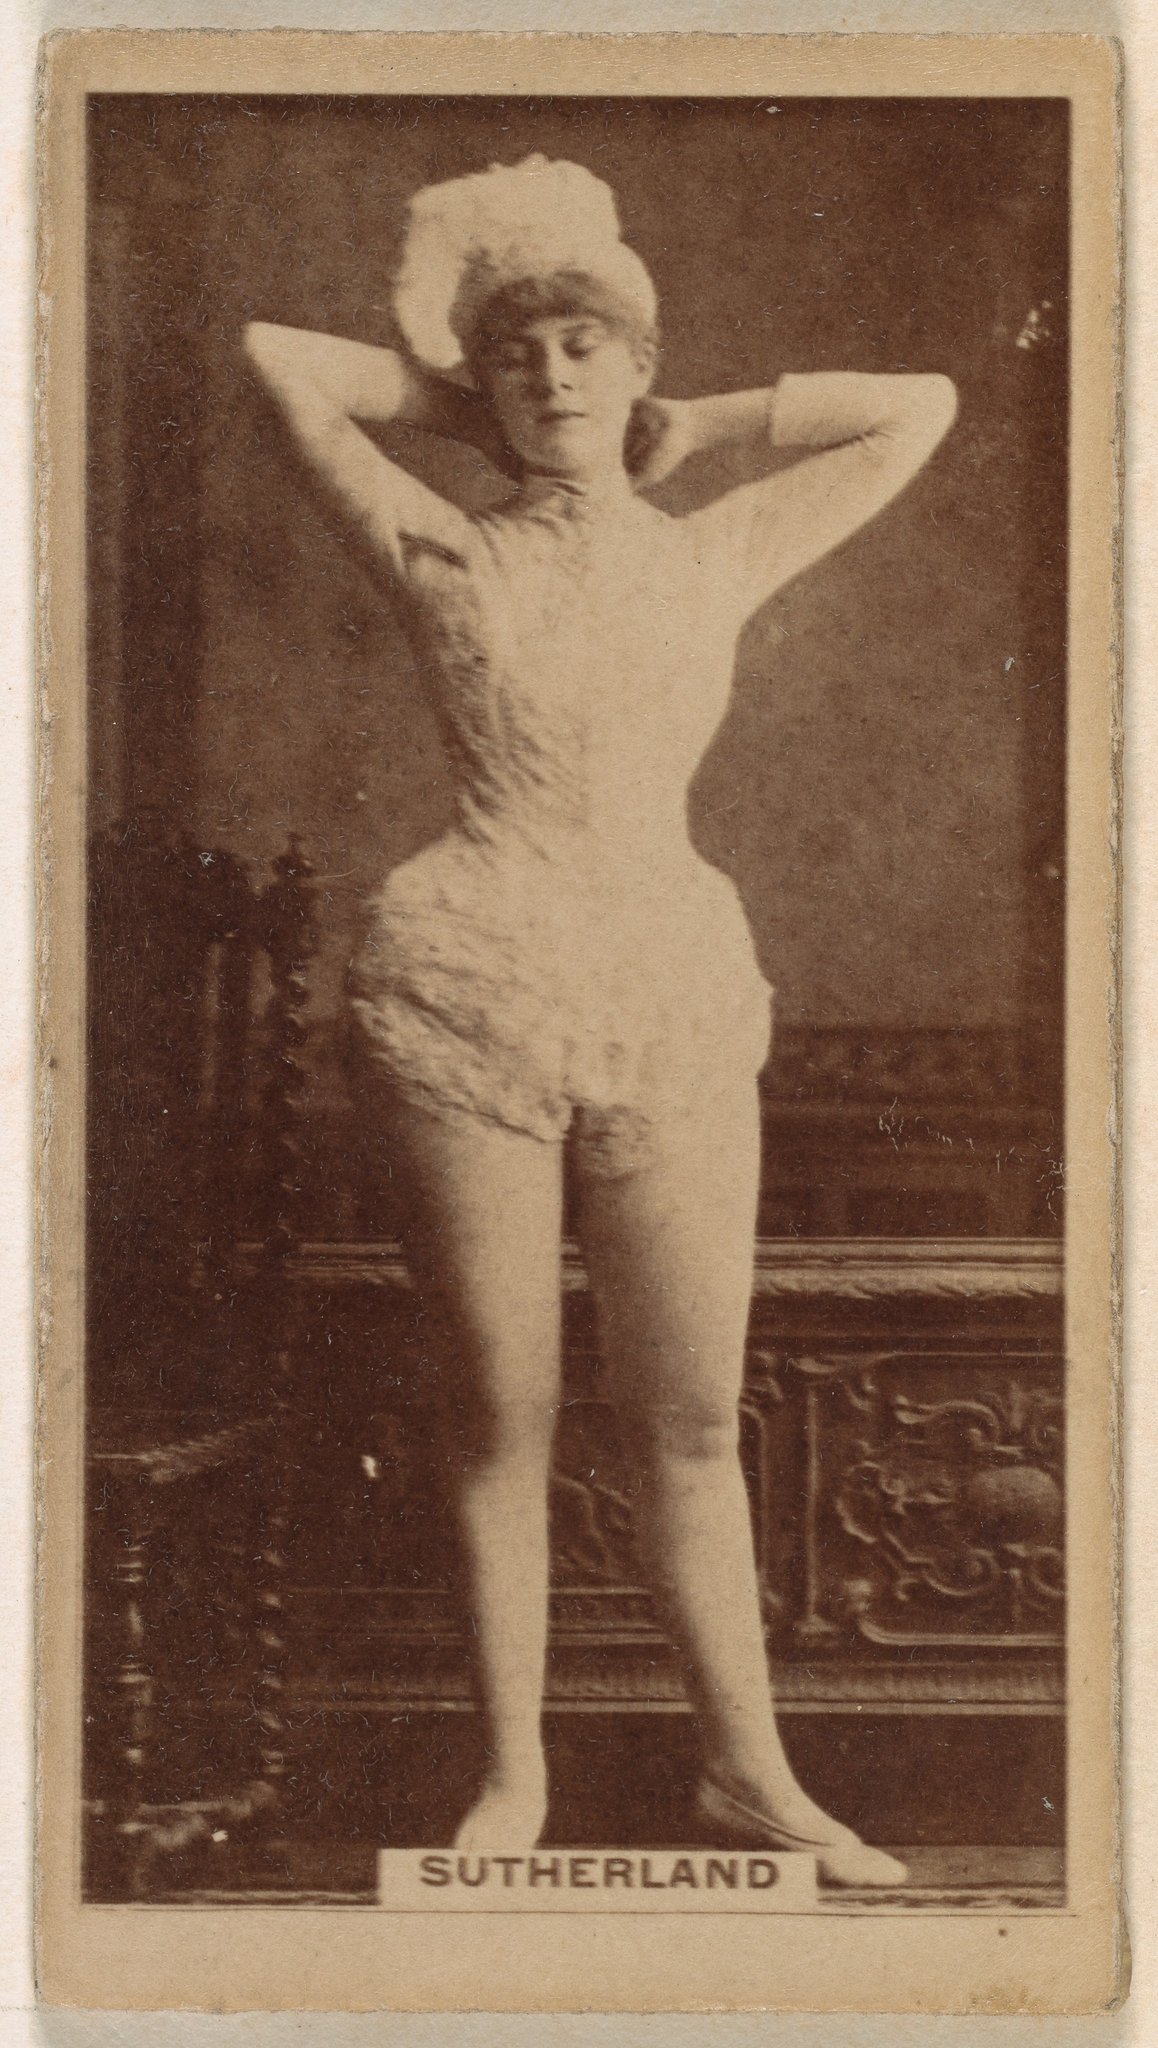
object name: photograph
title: Miss Sutherland, from the Actresses series (N245) issued by Kinney Brothers to promote Sweet Caporal Cigarettes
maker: kinney brothers tobacco company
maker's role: publisher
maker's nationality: american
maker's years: 1869-2011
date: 1890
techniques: albumen silver print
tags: portraits,women,actresses